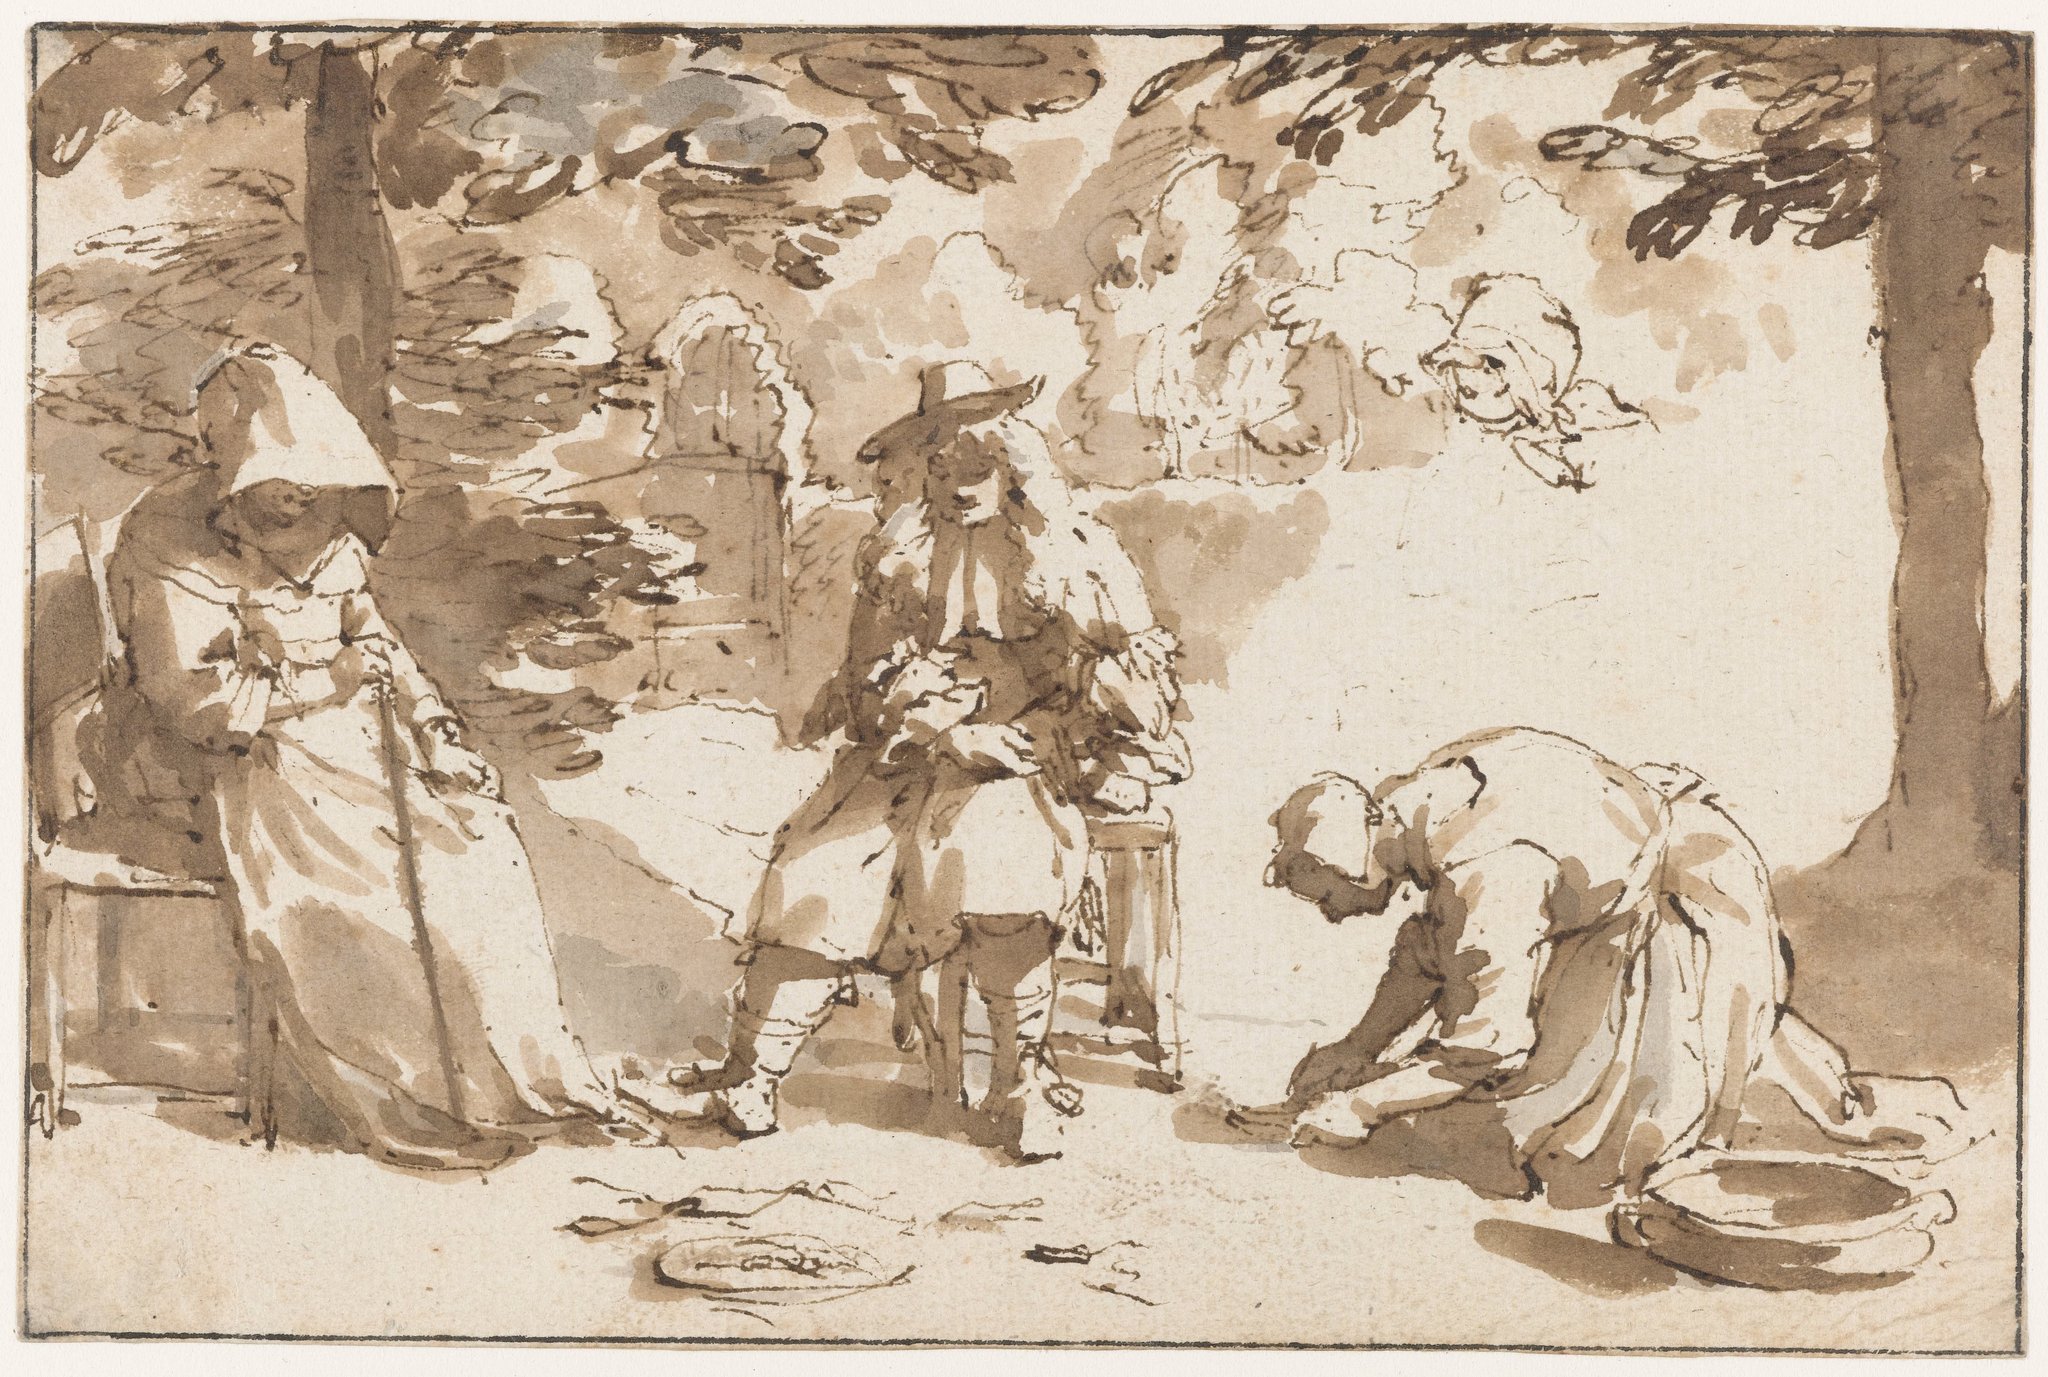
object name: drawing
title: Constantijn Huygens II in the Garden of Hofwijk Manor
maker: jan de bisschop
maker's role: draughtsman, print maker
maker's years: 1628-1671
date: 1648-1671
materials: ink, paper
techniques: brush, pen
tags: constantijn huygens (ii), garden, historical persons, maid ~ house personnel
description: Regrettably Jan de Bisschop did not make more of these informal scenes; as a draughtsman he was clearly in his element in this genre. De Bisschop’s friend Constantijn Huygens II is seated in the middle, between his aunt and a maidservant. His hat is perched at a rakish angle on his bewigged head. Hofwijk Manor, near Voorburg, was built to the plans of his father, the statesman, poet and composer Constantijn Huygens I.